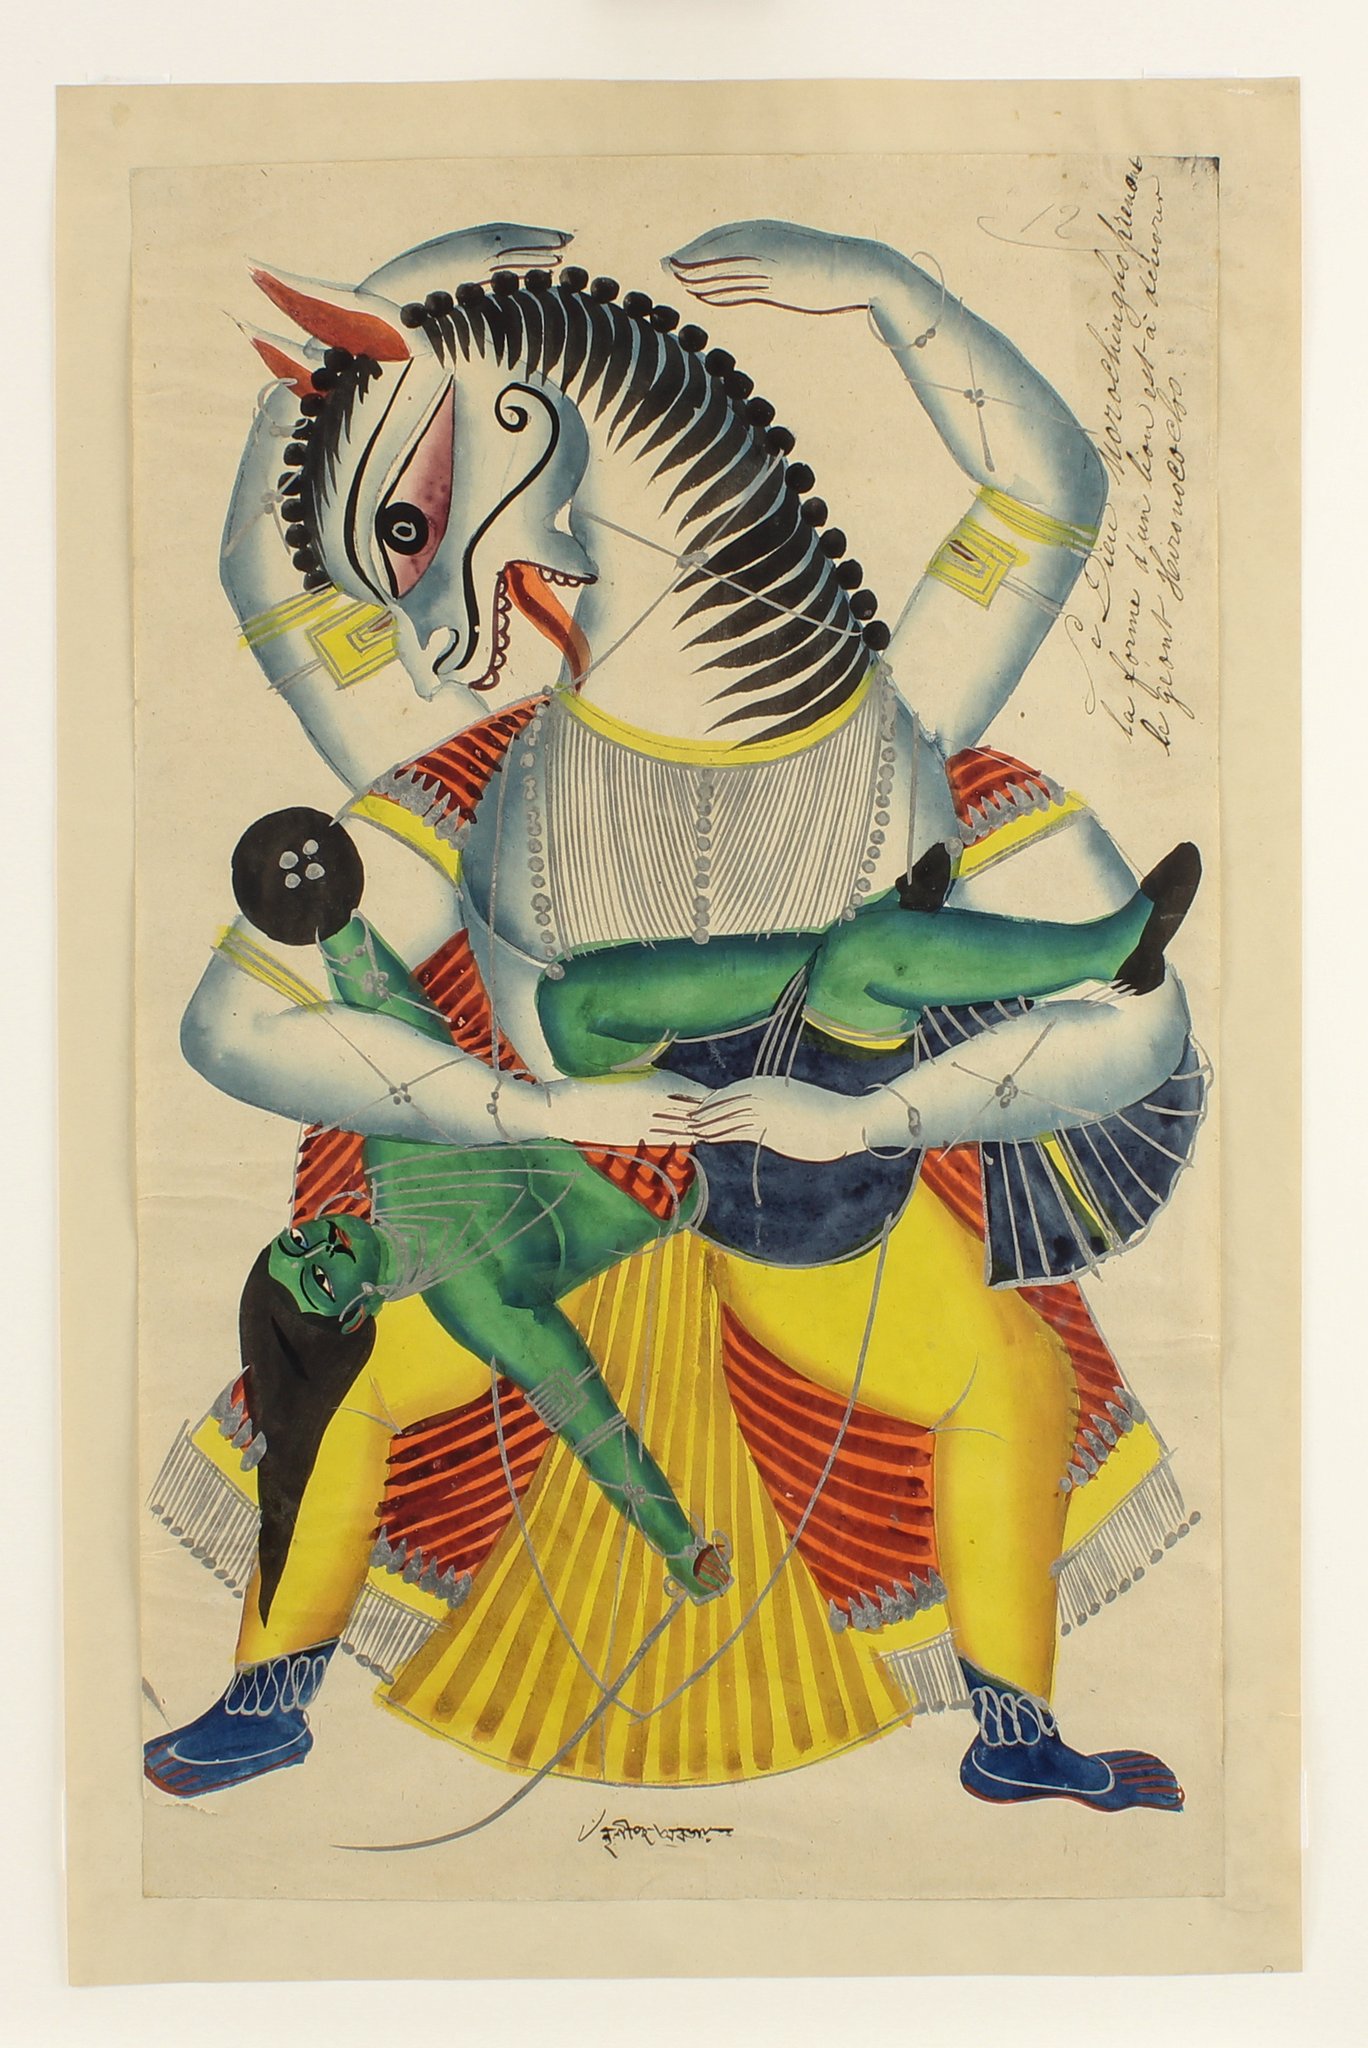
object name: painting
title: The avatar Narasimha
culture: indian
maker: unidentified artist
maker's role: artist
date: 1870-1879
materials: graphite, ink, paper, tin, watercolor